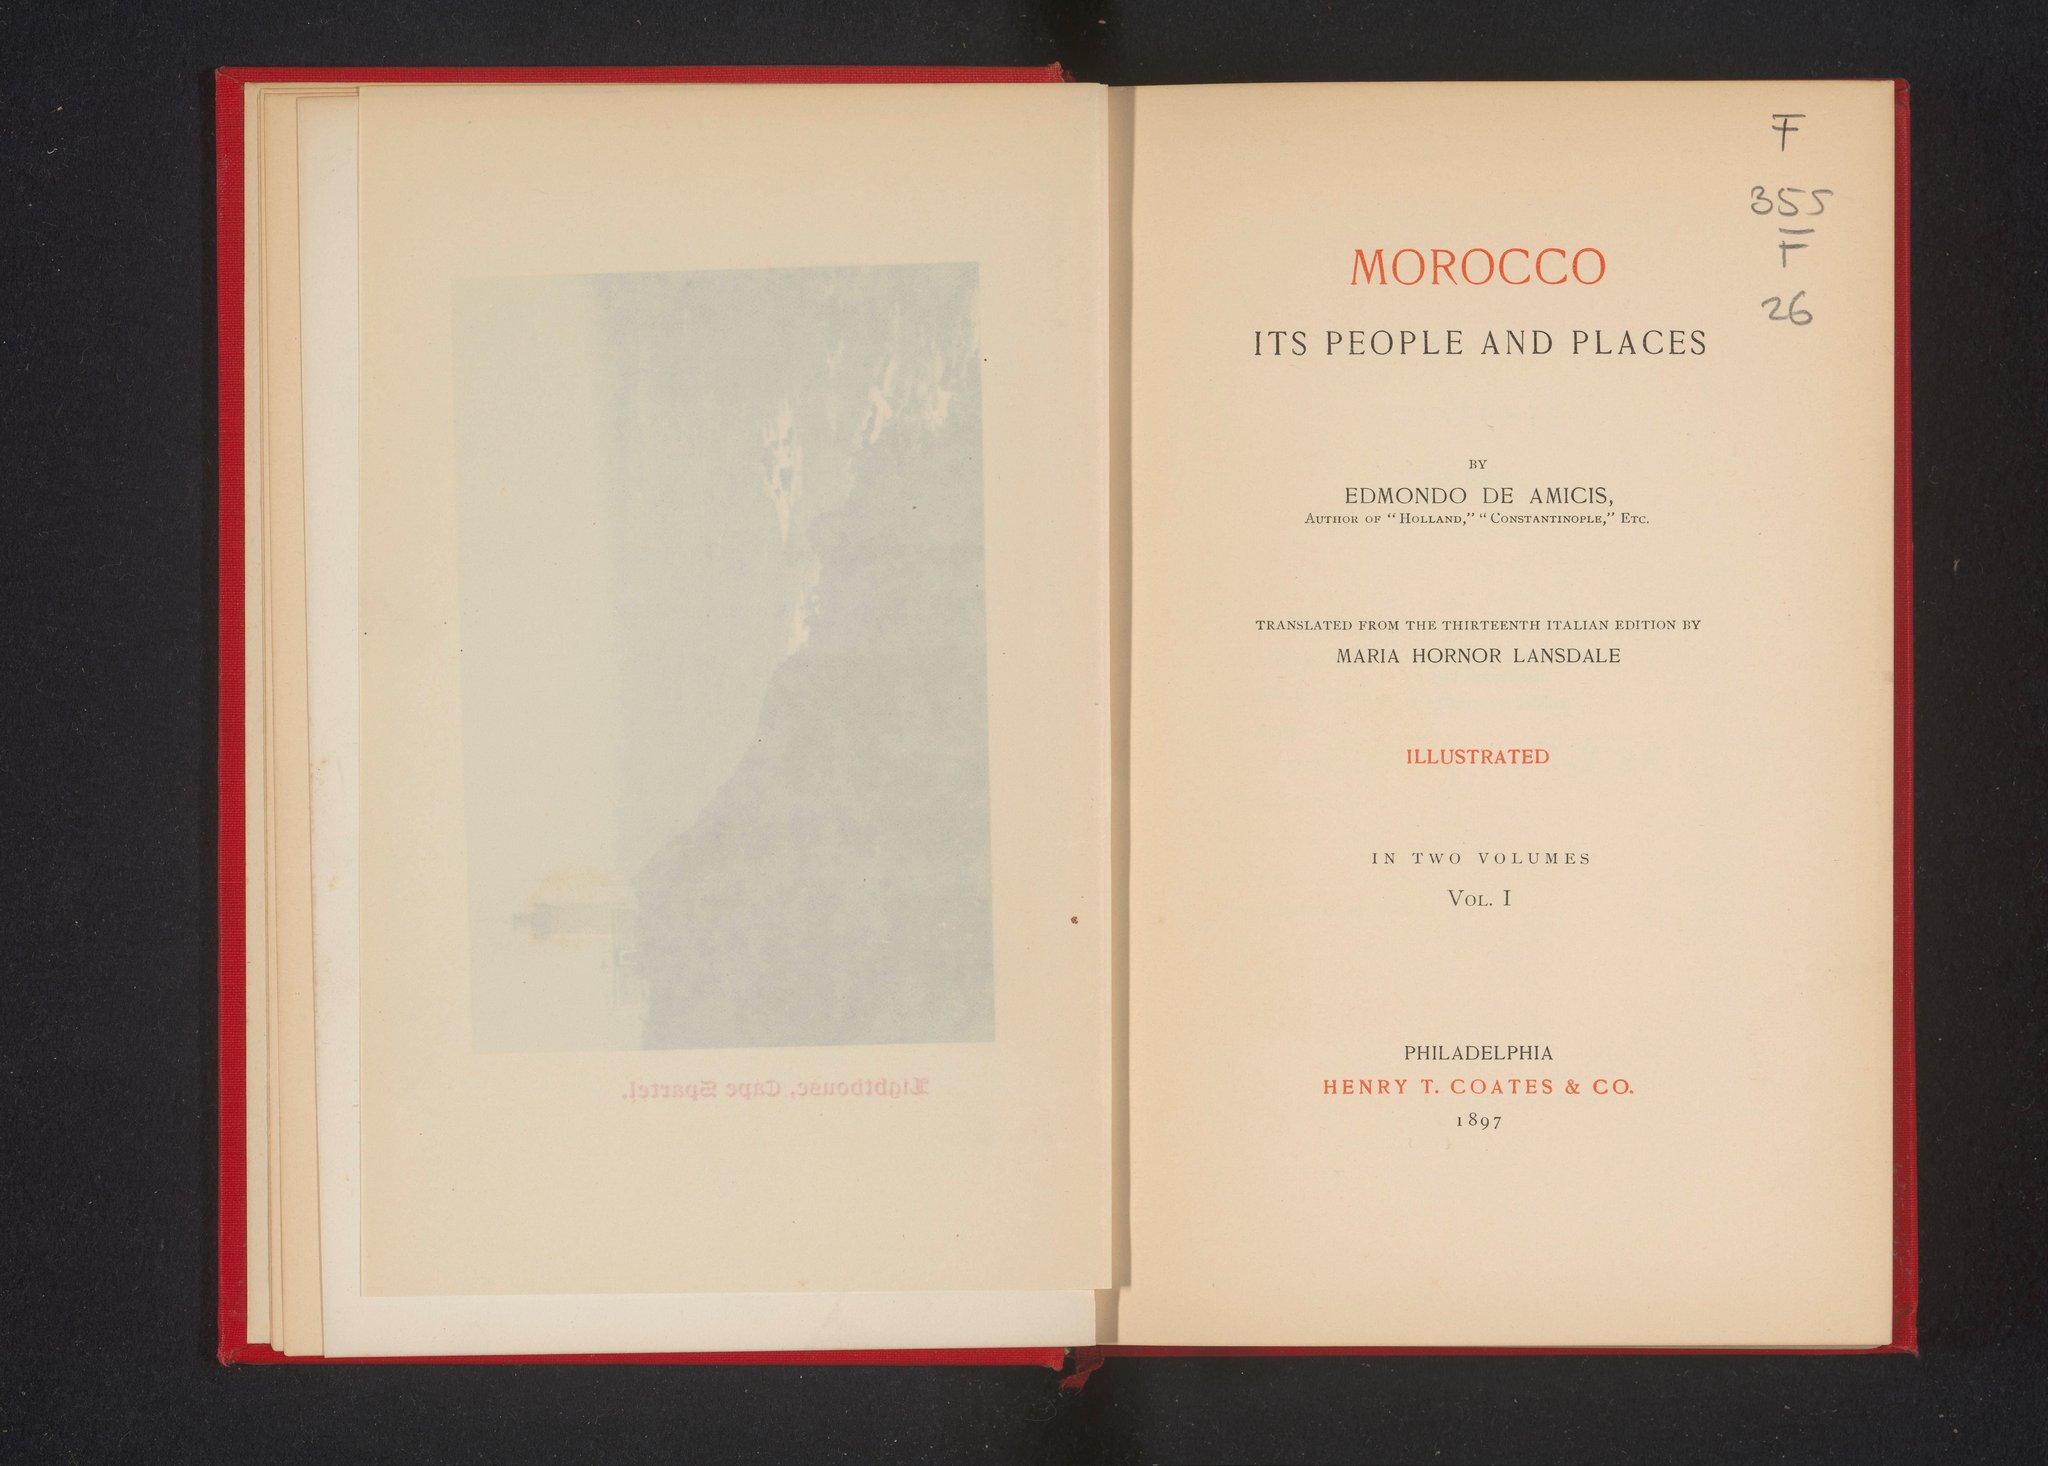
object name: book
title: Morocco its people and places vol. I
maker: edmondo de amicis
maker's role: schrijver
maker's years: 1846-1908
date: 1897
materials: cardboard, linen, paper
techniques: photoaquatint, printing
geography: philadelphia